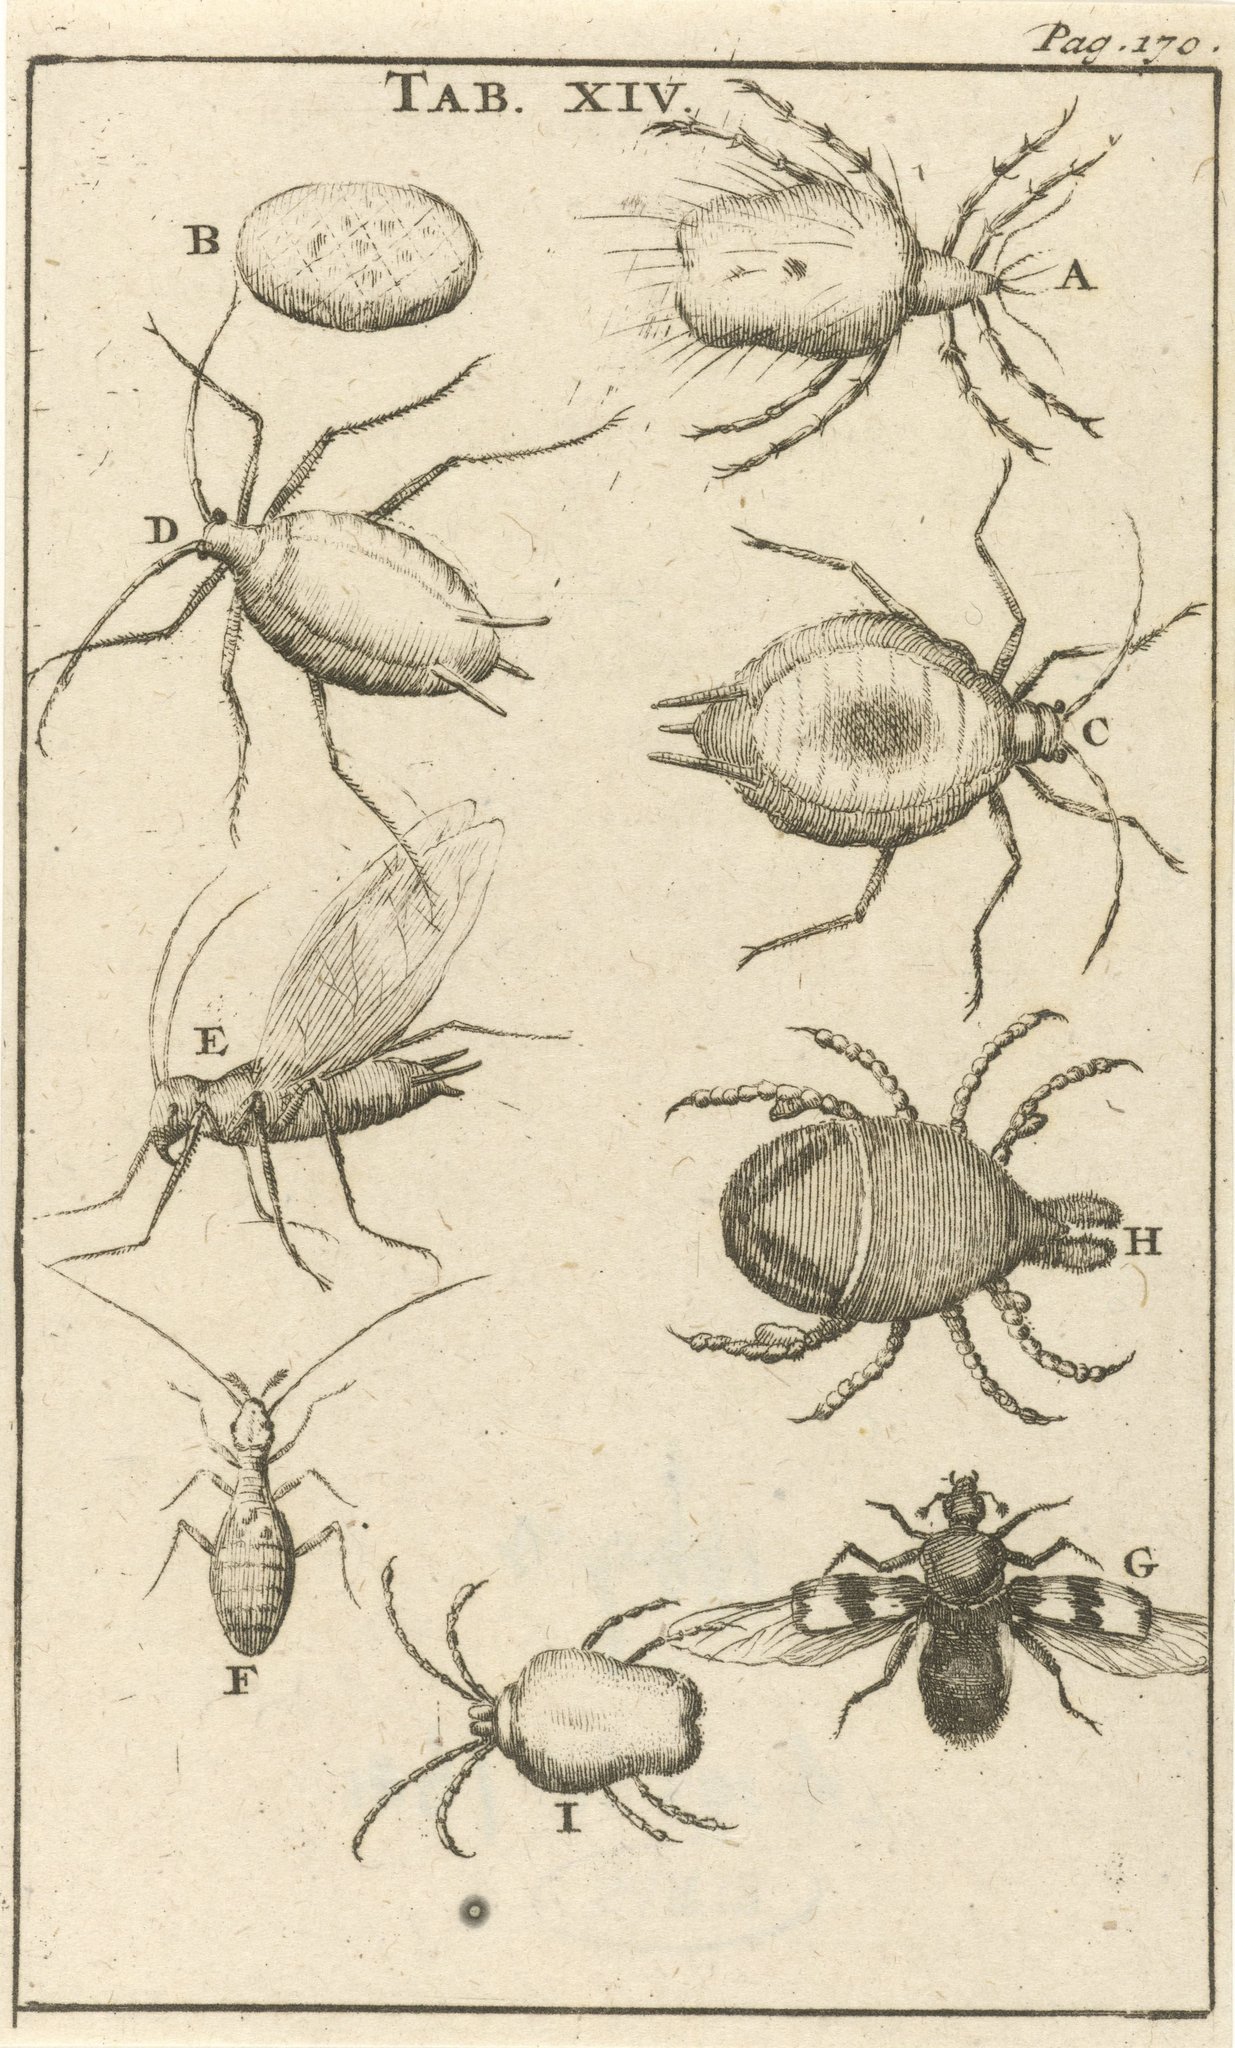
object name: print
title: Wandgedierte XIV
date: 1680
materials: paper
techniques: etching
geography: amsterdam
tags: insects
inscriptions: collector's mark: Lugt 2228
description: Illustratie opgenomen in: Blankaart, Steven. Schou-burg der rupsen, wormen, ma'den, en vliegende dierkens daar uit voortkomende. Amsterdam: Jan Claesz ten Hoorn, 1680.